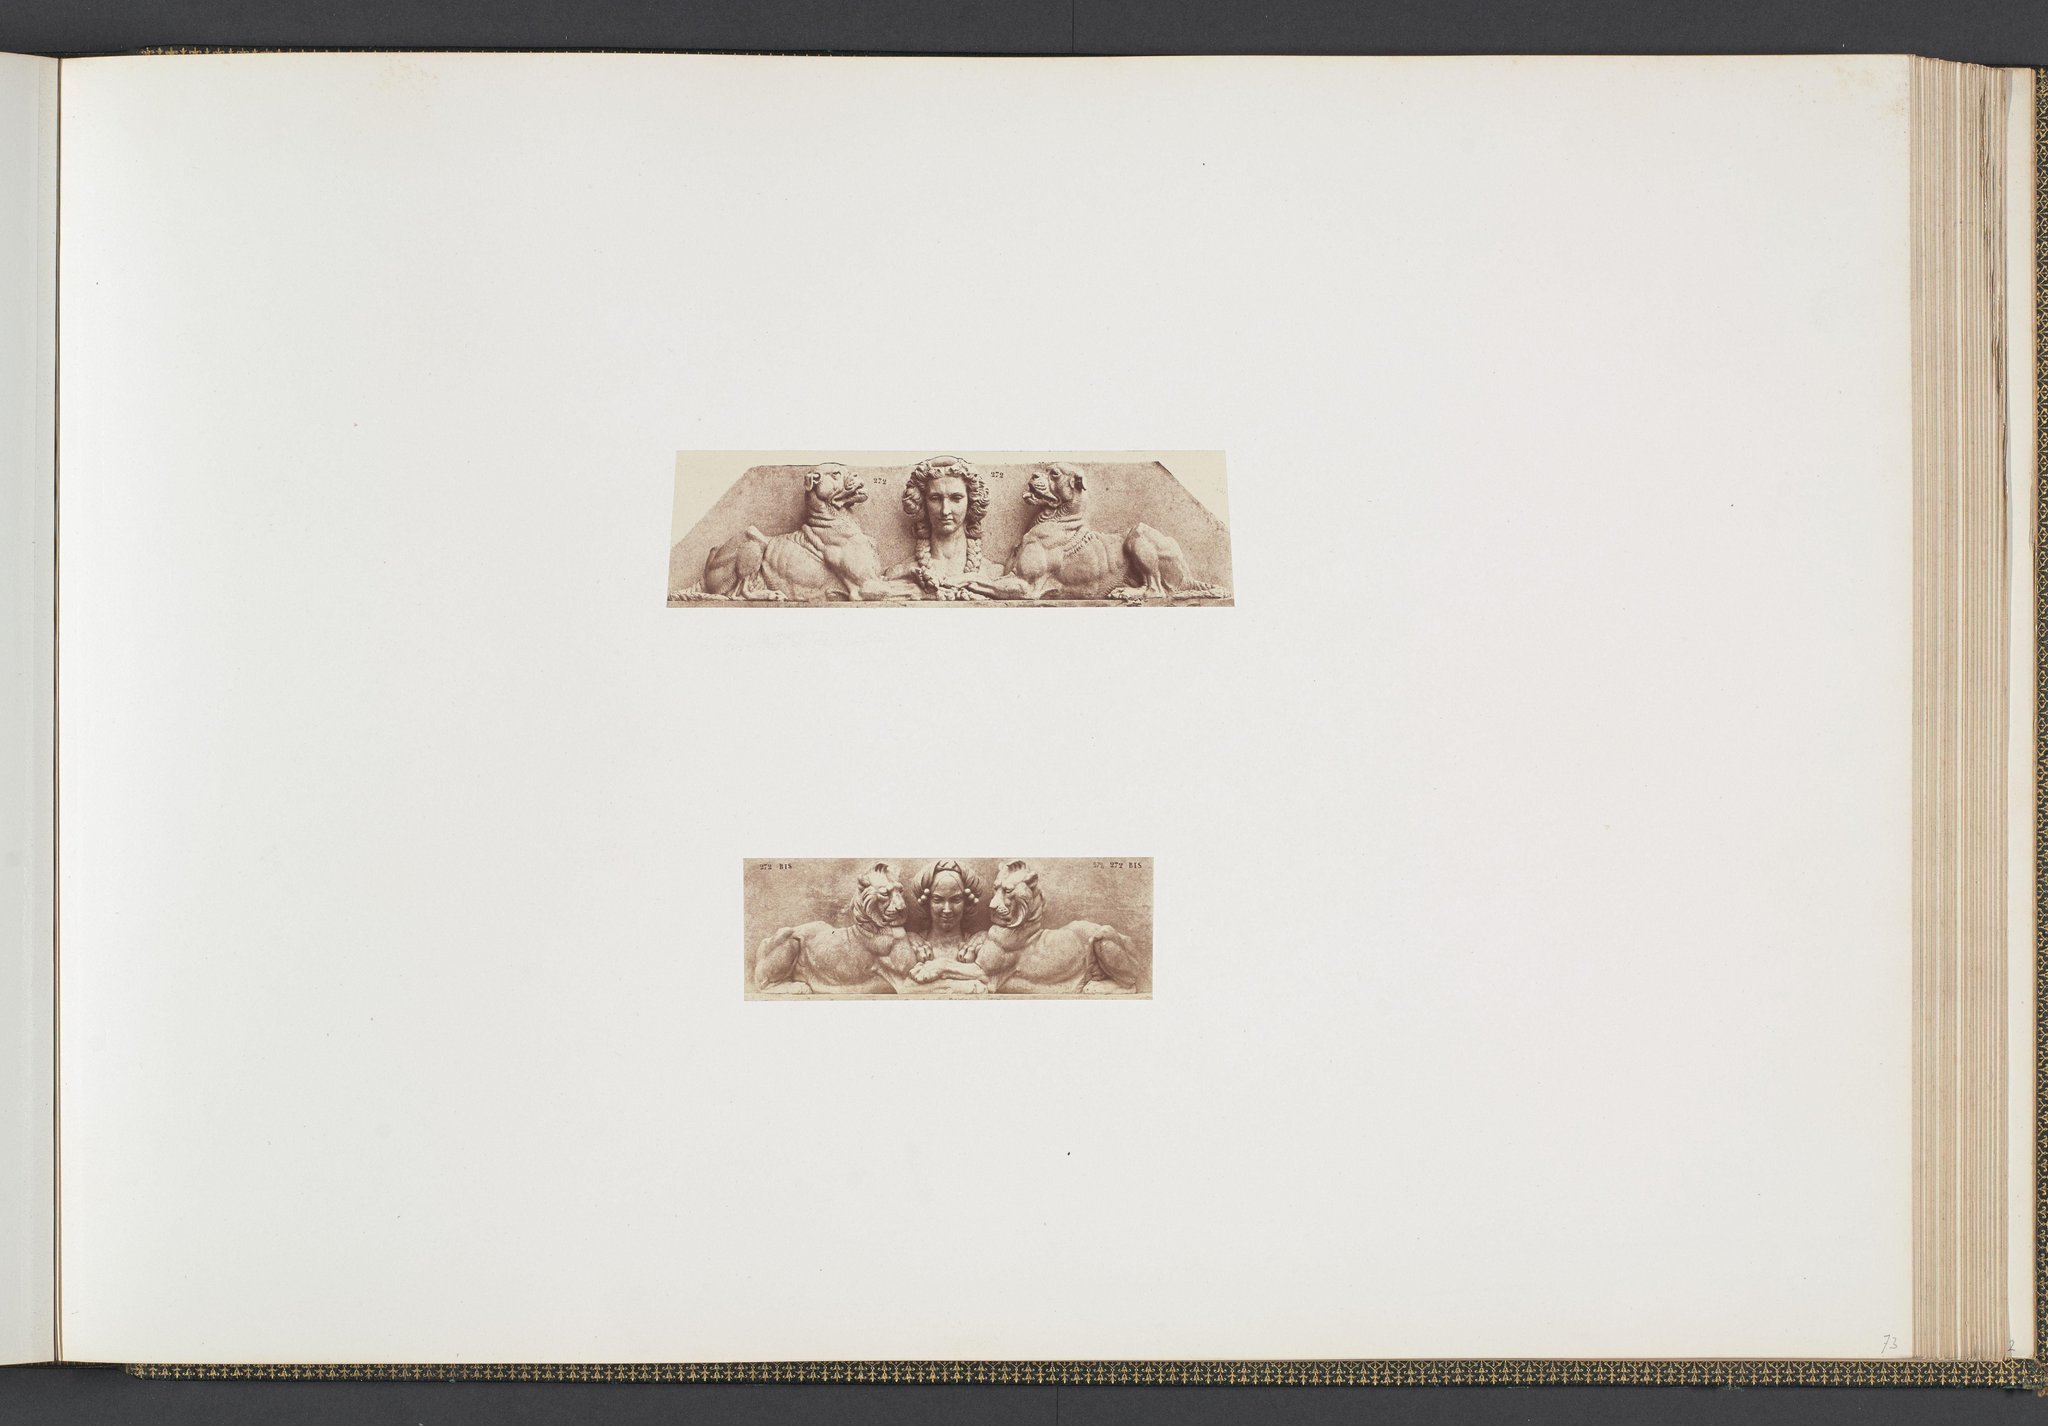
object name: photograph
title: Gipsmodellen voor beeldhouwwerken op het Palais du Louvre: boven twee doggen en een mannenhoofd, beneden twee leeuwen en een vrouwenhoofd, beide door Emmanuel Fremiet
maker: édouard denis baldus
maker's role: fotograaf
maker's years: 1813-1889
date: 1855-1857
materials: paper, photographic support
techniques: salted paper print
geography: paris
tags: piece of sculpture, reproduction of a piece of sculpture, permanent exhibition, museum, paris, tuileries palace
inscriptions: number: ‘272 (boven) en 272 bis (beneden)’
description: Onderdeel van Réunion des Tuileries au Louvre 1852-1857, album 2.